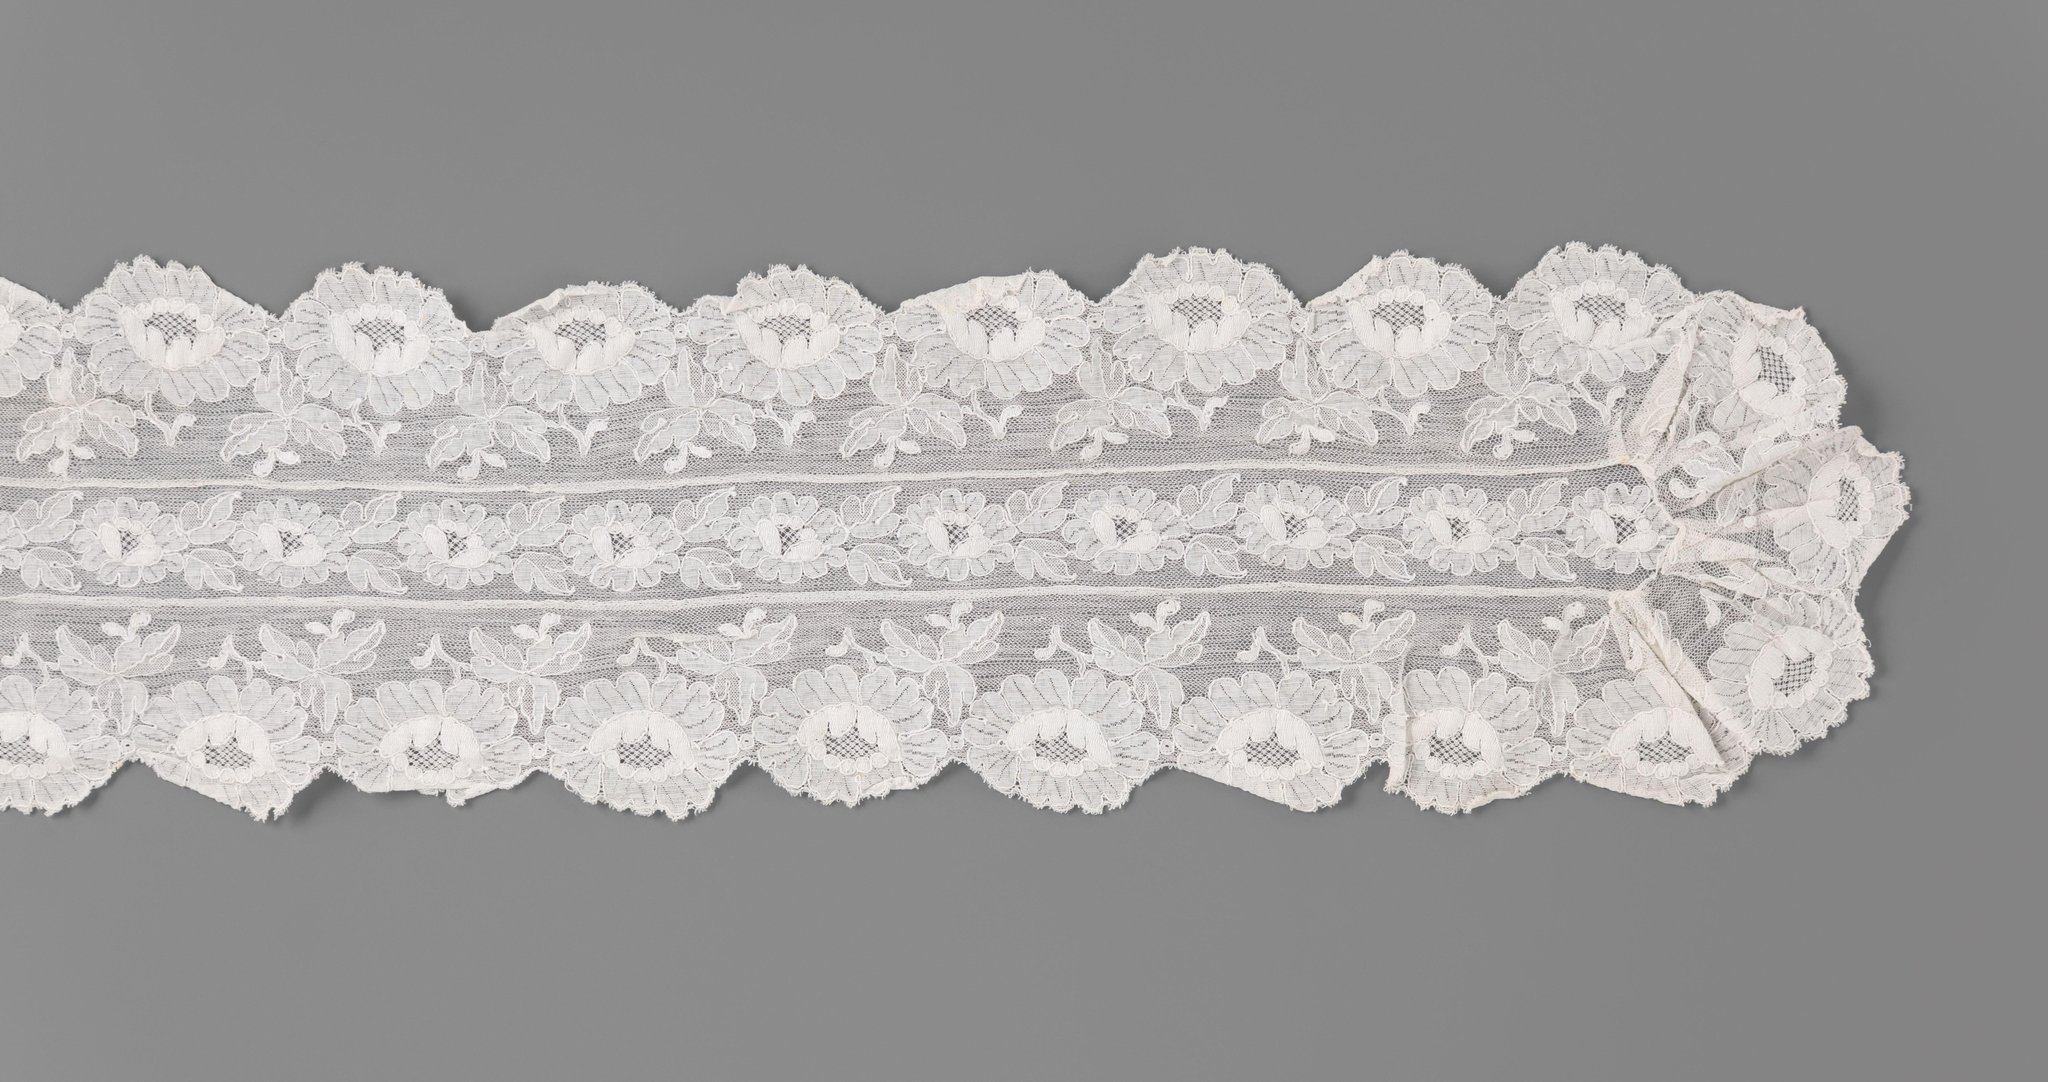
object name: womenswear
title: Strikdas van machinale kant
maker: Anonymous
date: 1880-1900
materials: lace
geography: western europe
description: Strikdas van machinale kant met geschulpte rand voorzien van picots. De schulpen worden gevormd door bloemen, daartussen telkens een bladertak.